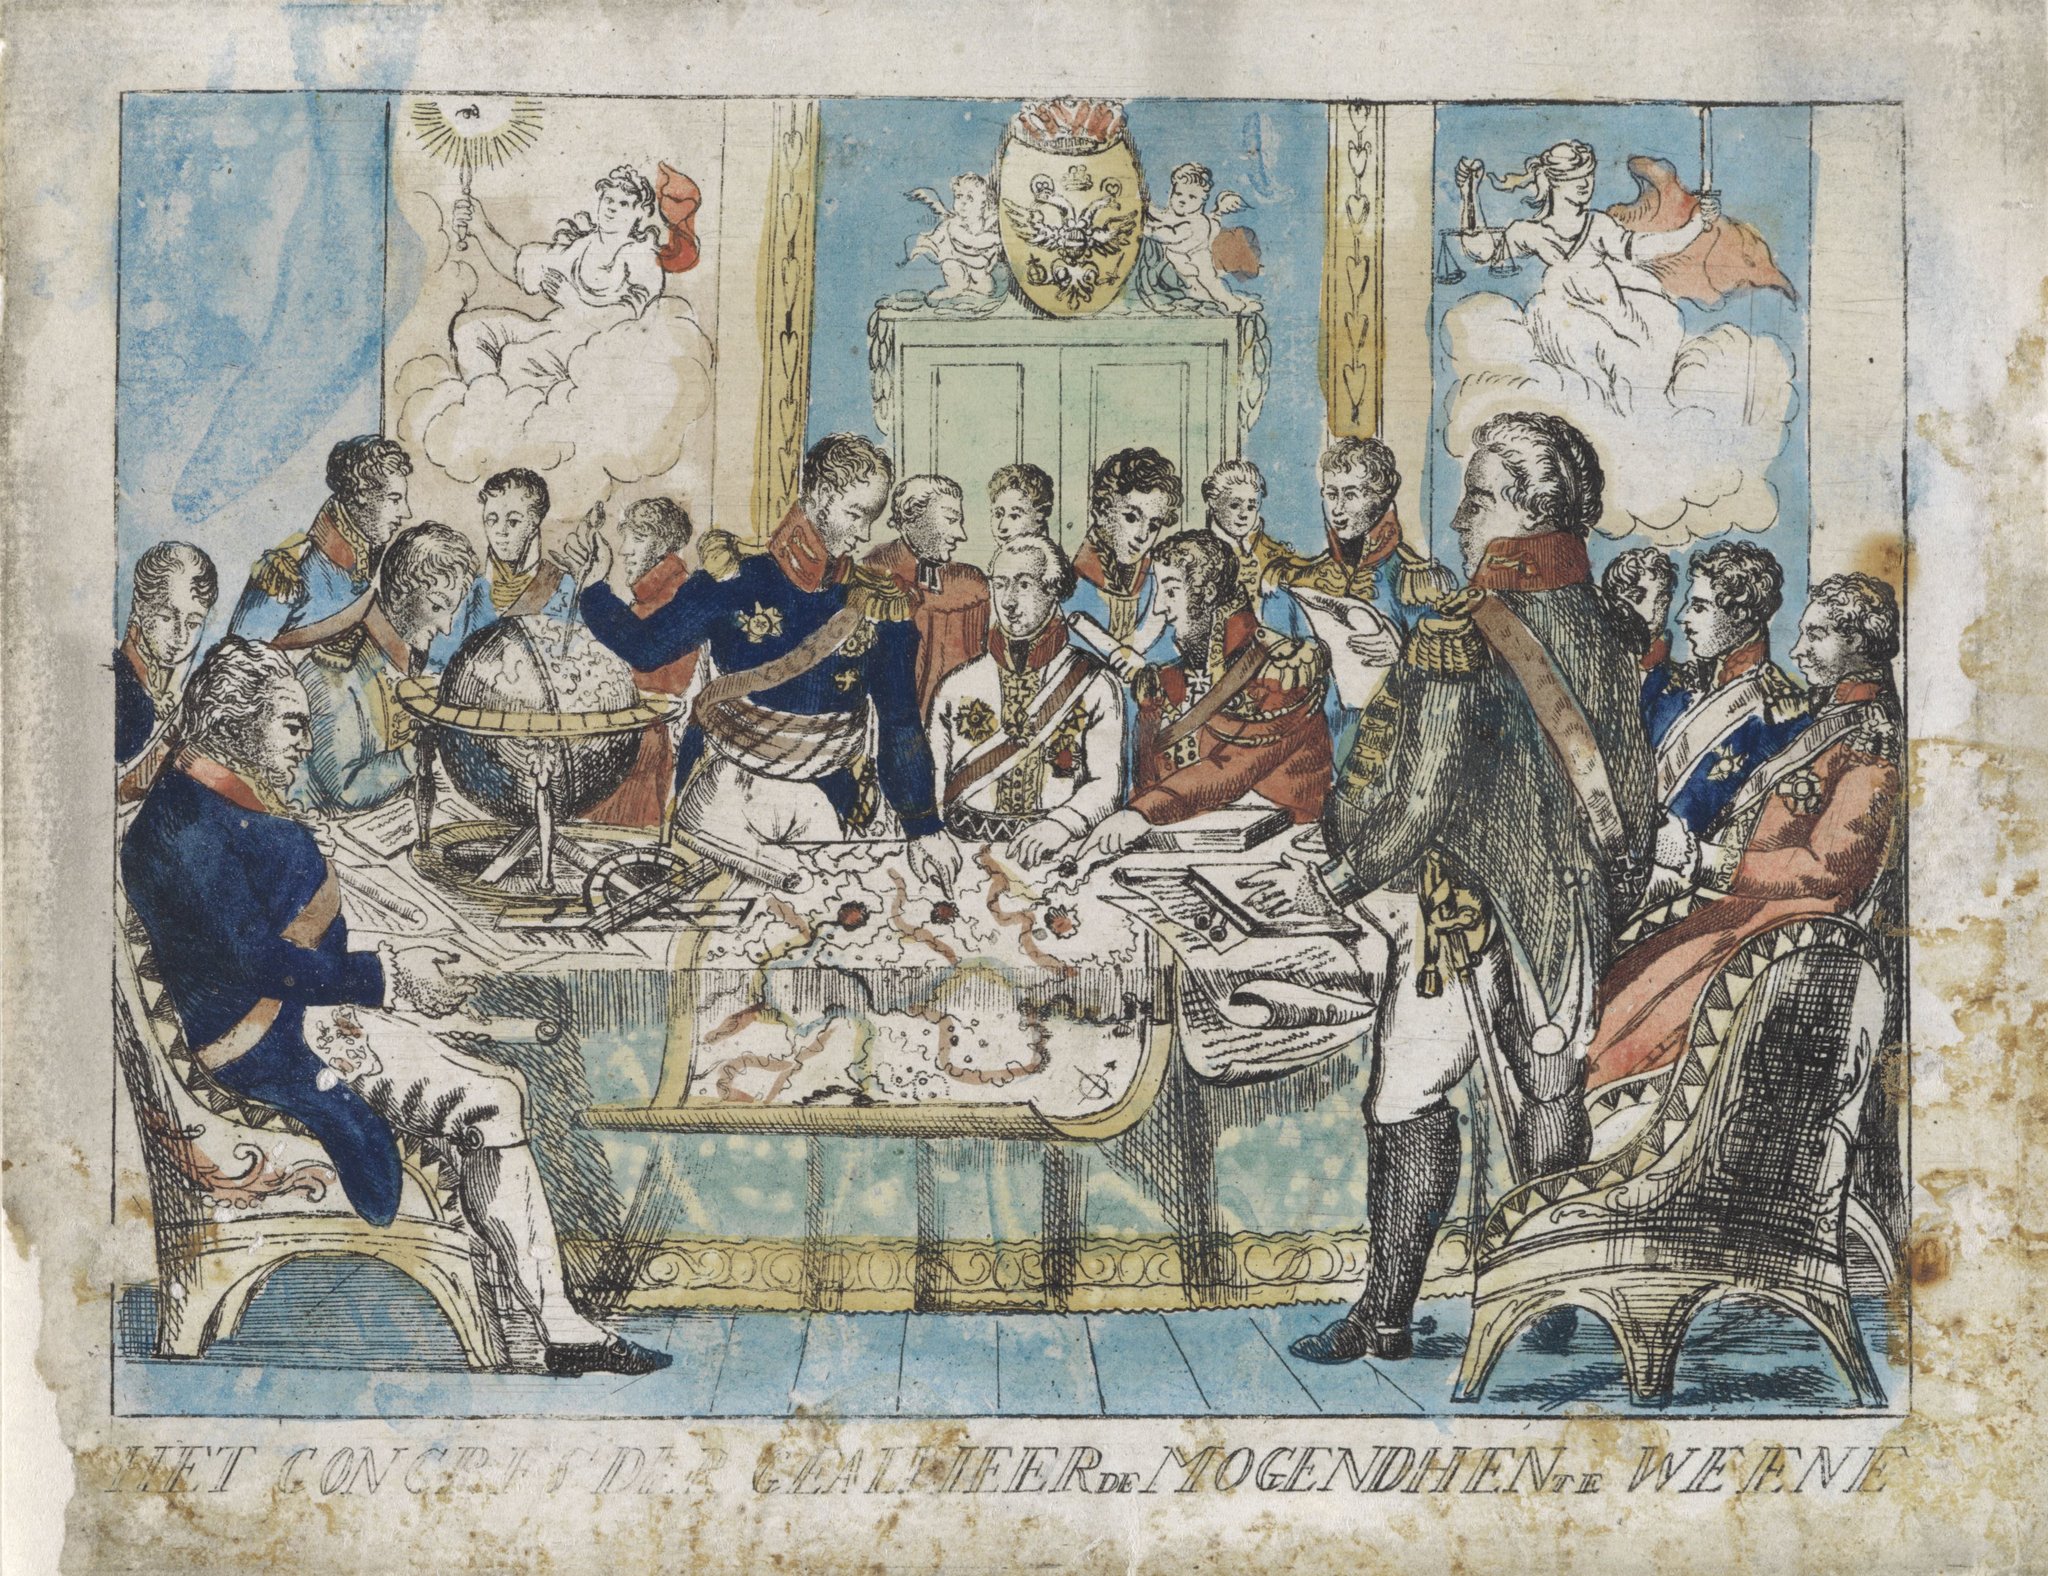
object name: print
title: Het Congres der Geallieerde Mogendhen te Weenen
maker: Anonymous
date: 1815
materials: paper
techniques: etching, hand coloring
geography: netherlands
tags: negotiations, conference ~ diplomacy, vienna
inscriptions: collector's mark: Lugt 2228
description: Beraadslagingen tijdens het Congres van Wenen, 1815. De diplomaten vergaderen rond een tafel waarop een grote landkaart ligt. Aan de wand twee allegorische schilderijen.